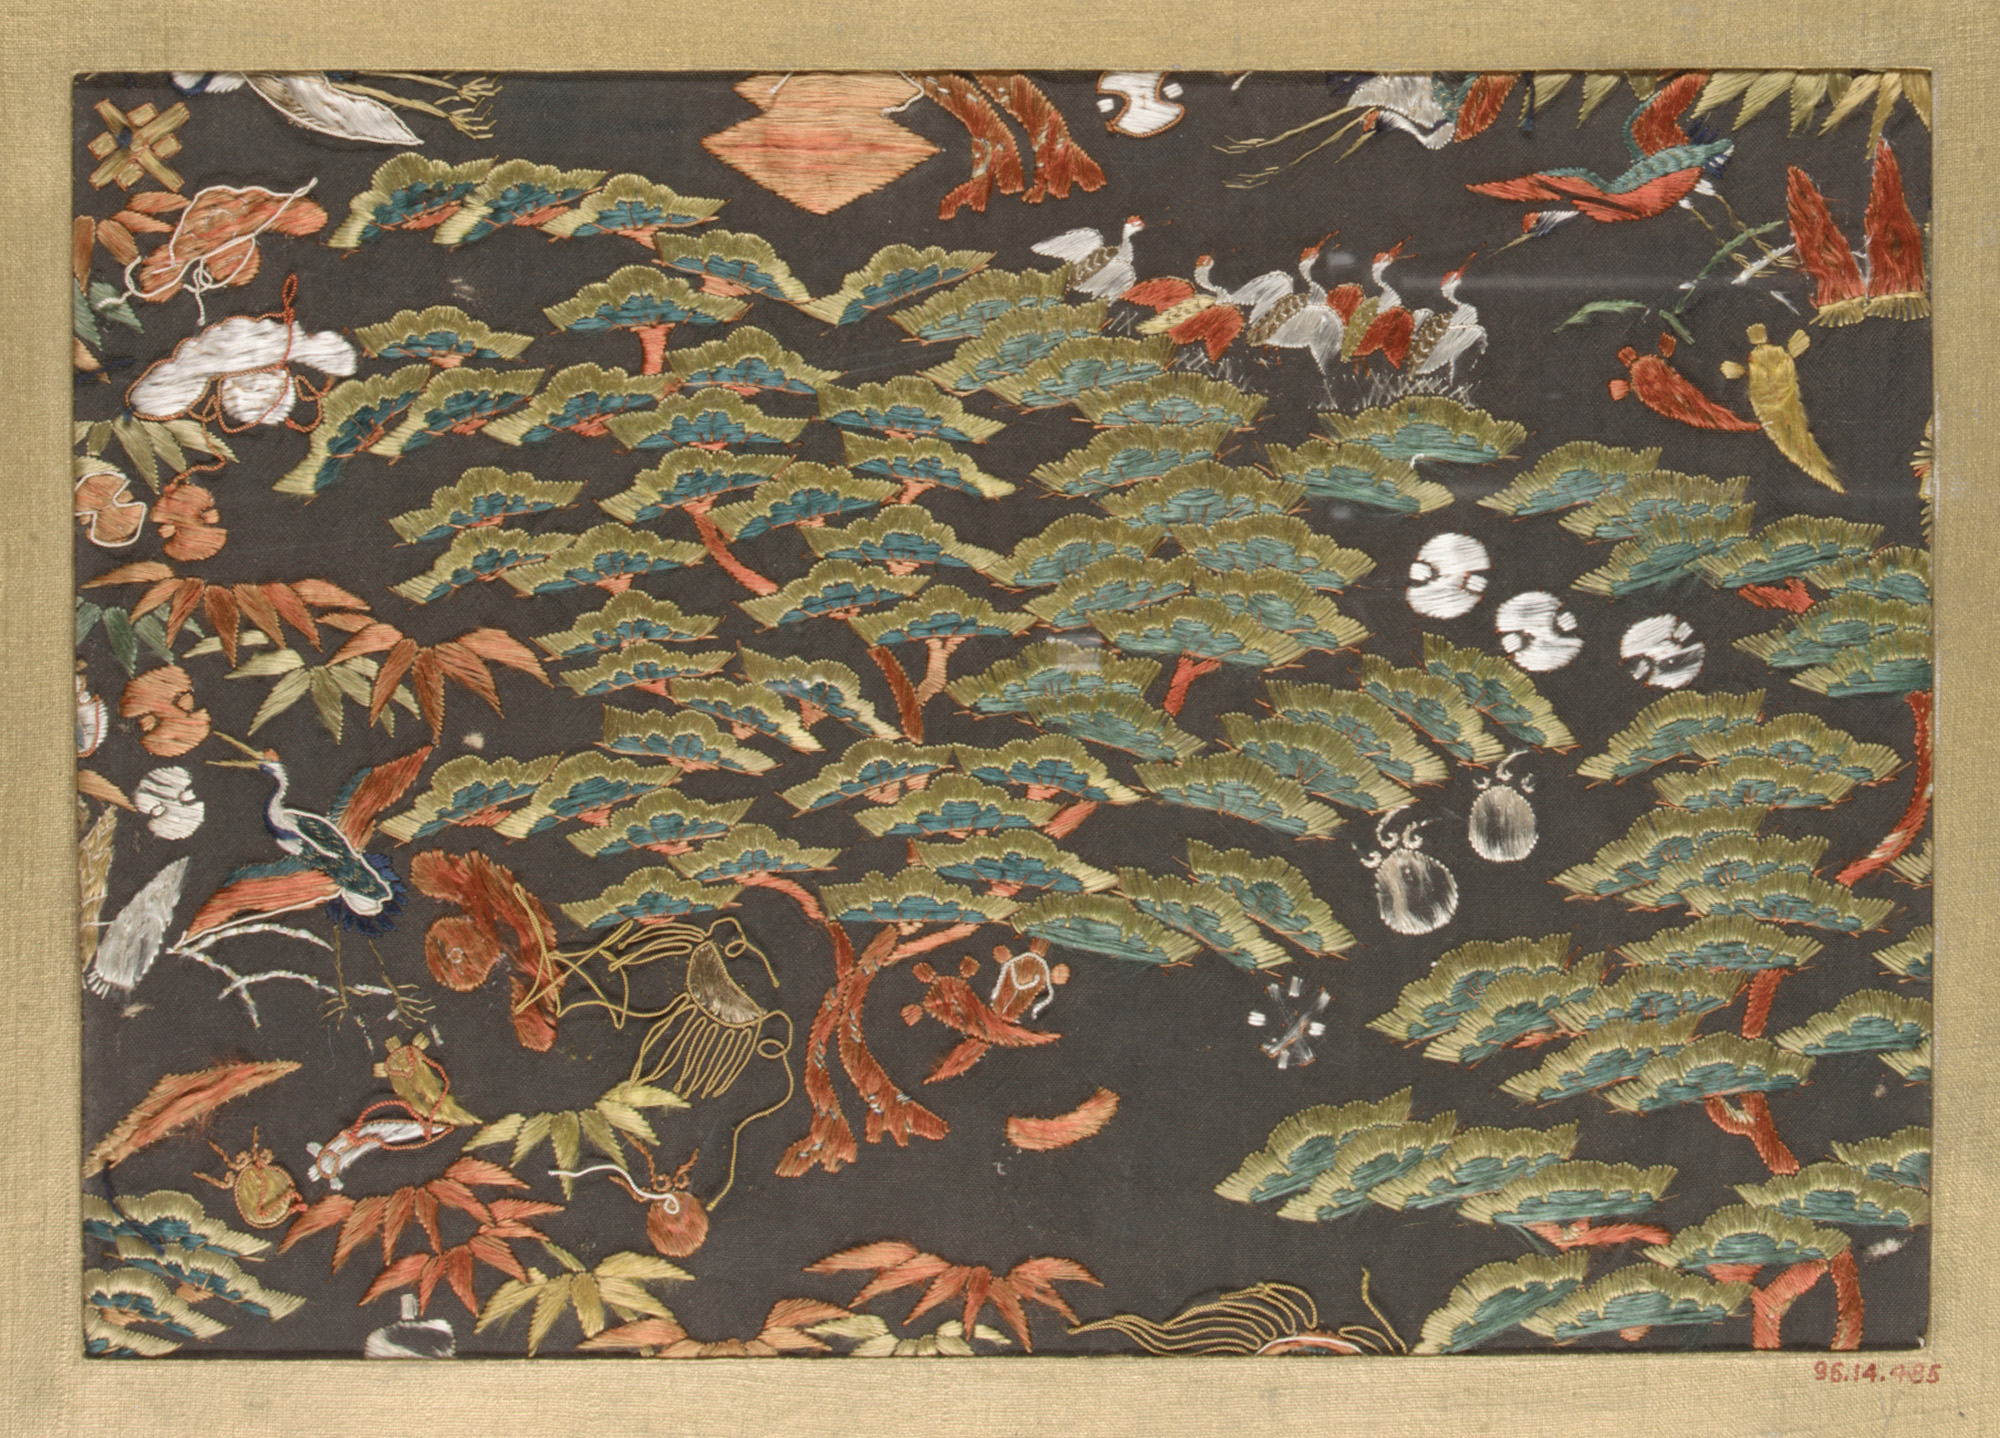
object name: fragment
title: Textile fragment with pattern of pine, cranes, and auspicious symbols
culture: japanese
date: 1701-1900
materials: silk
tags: cranes,leaves,trees